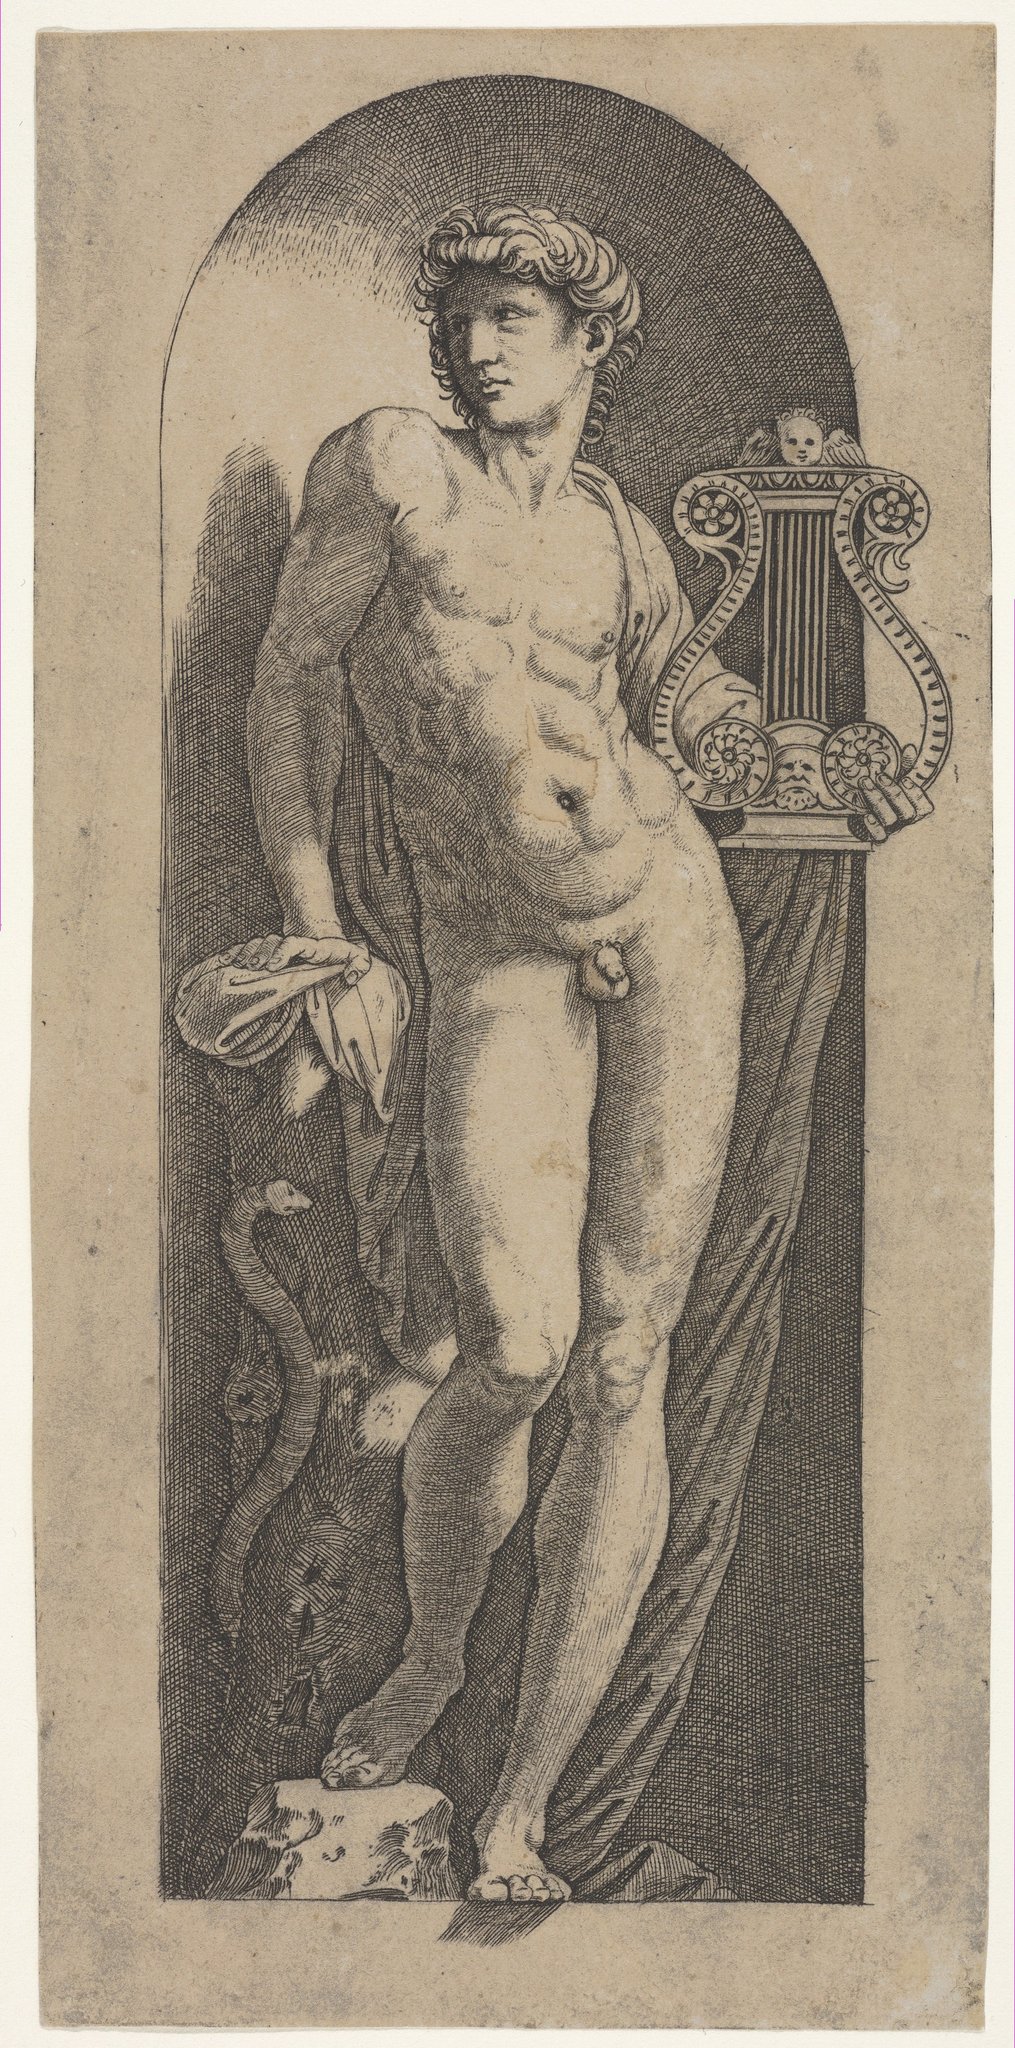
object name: print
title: A statue of Apollo, naked standing in a niche, holding a lyre in his left hand and leaning on a tree trunk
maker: marcantonio raimondi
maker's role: artist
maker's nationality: italian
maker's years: 1475-1534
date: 1512-1515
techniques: engraving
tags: harps,apollo